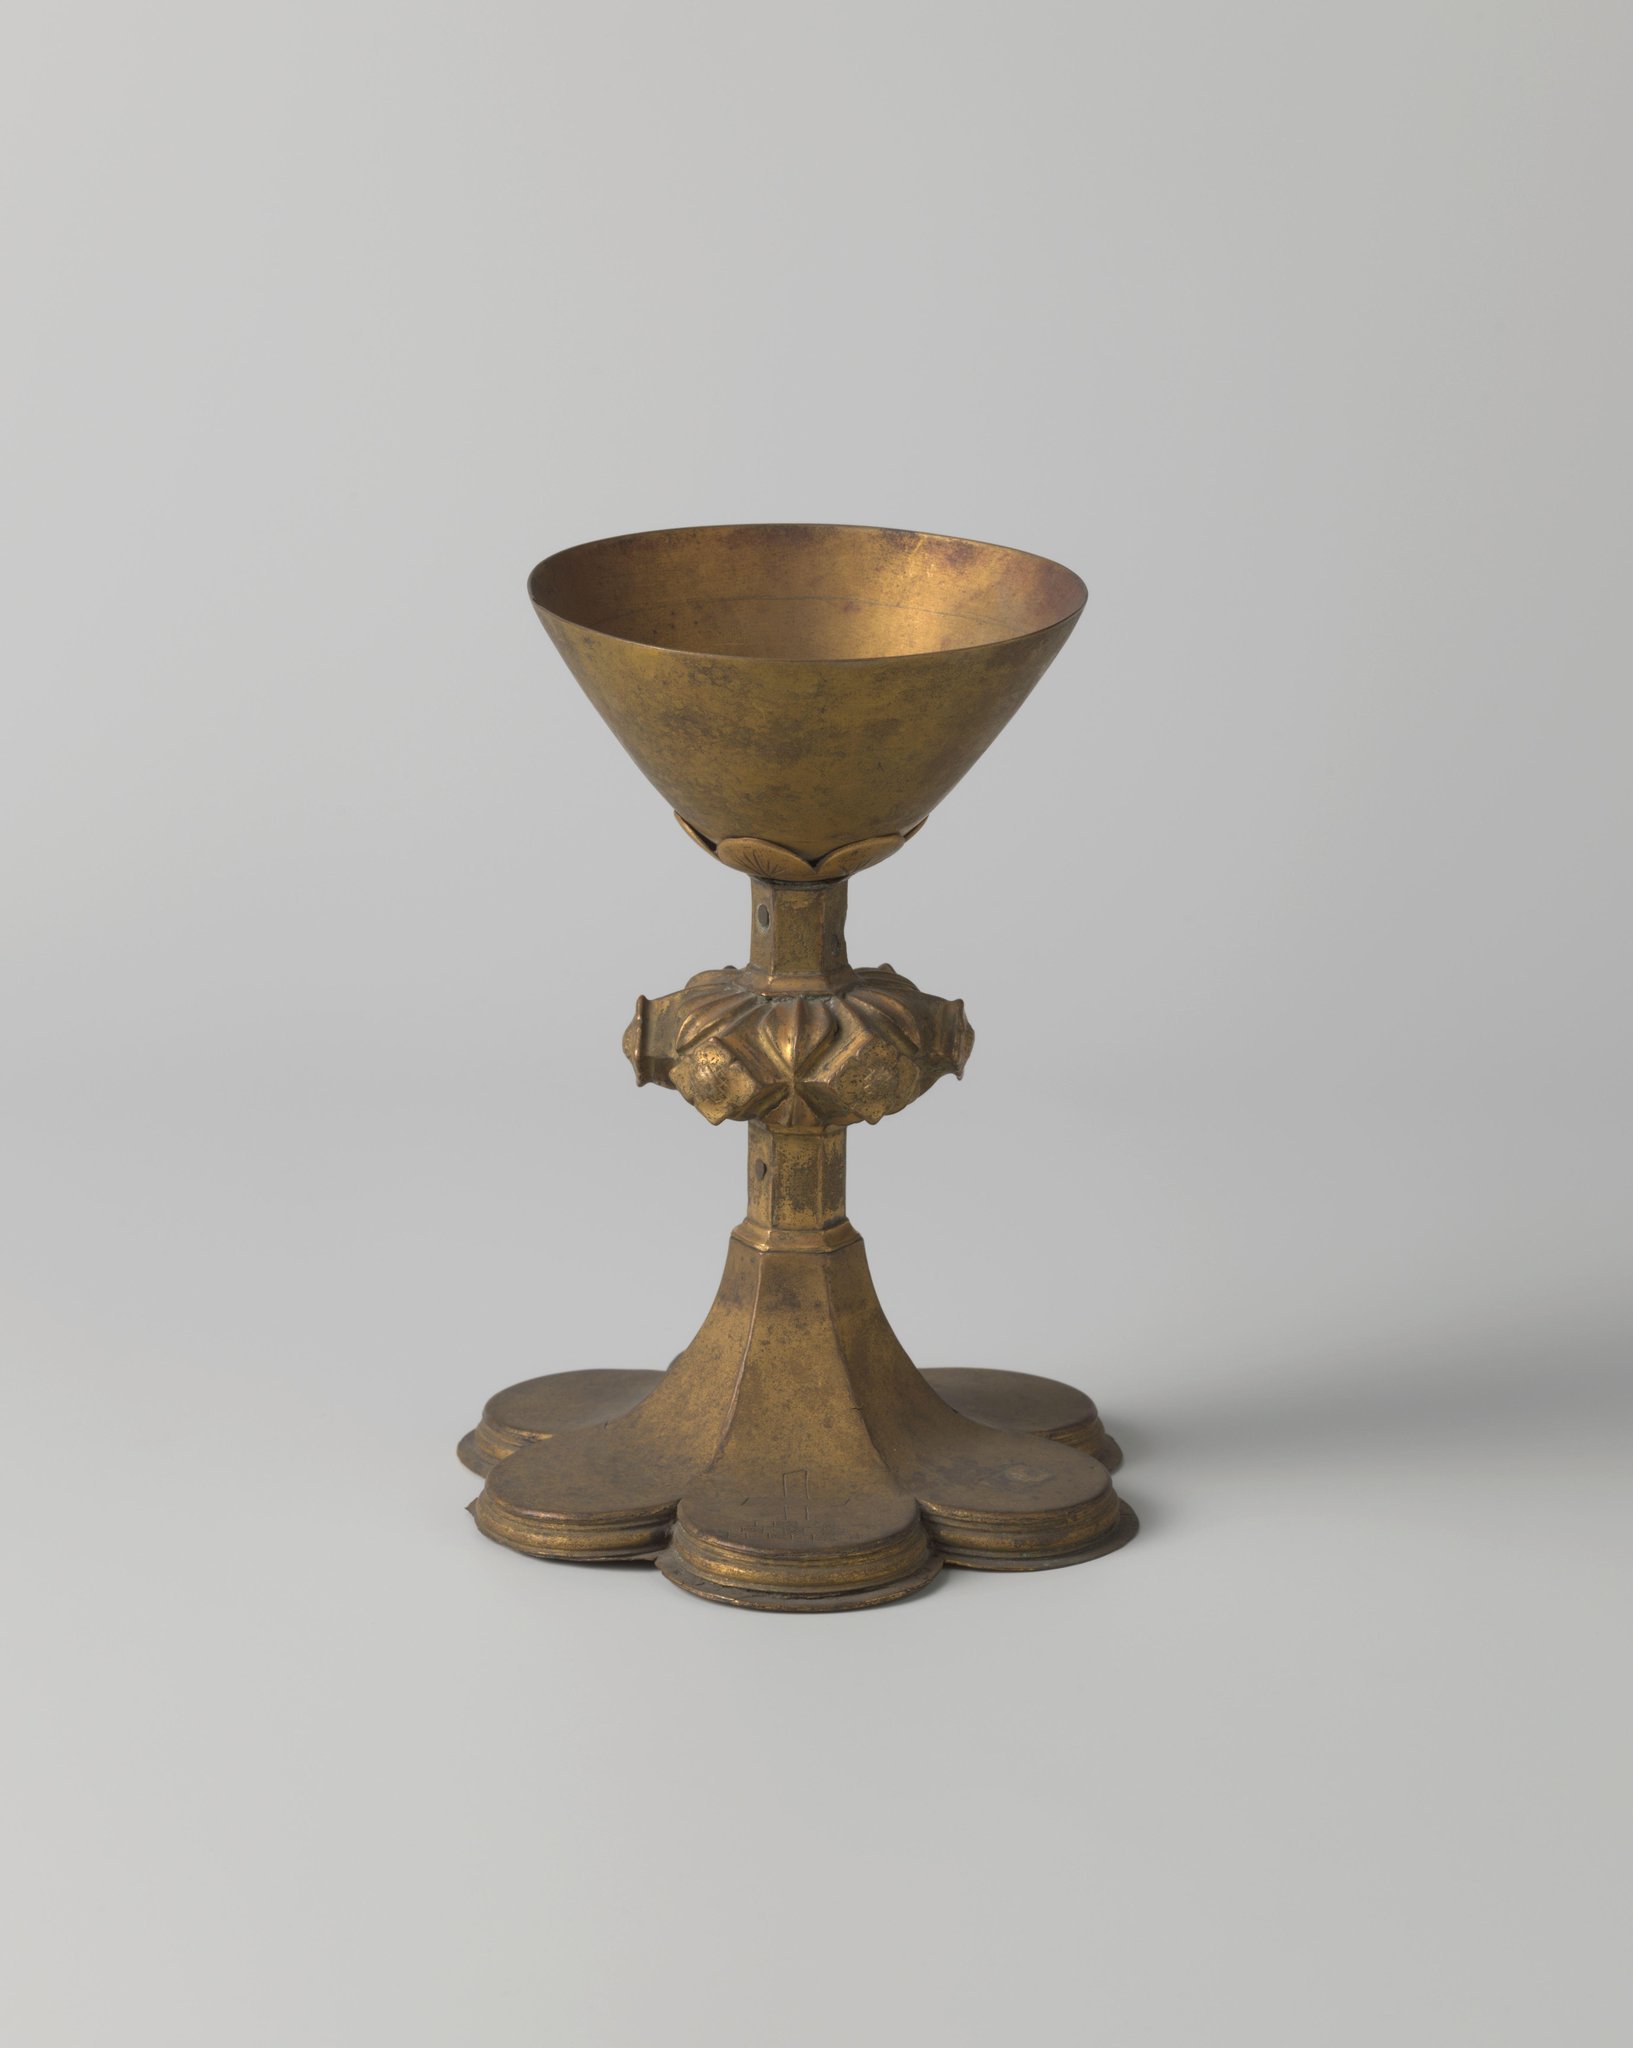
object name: chalice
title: Miskelk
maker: Anonymous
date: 1475-1525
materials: brass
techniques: metalworking, engraving, gilding, riveted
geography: germany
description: Het gedreven en geciseleerde voorwerp bestaat uit voet (met de rand), stam, nodus en cuppa. Om de stam zijn het onderste stamdeel, de nodus en het bovenste deel aangebracht en geklonken. De cuppa is op de rozet bevestigd. De voet heeft zes lobben met een geprofileerde uitlopende rand, die in zes delen tegen de voet is aangebracht. Op één van hen is een kruis met schuine einden op een geblokt veld gegraveerd. De nodus heeft zes facetten, waarop vierbladige gestileerde rozetten, alsmede aan boven- en onderkant zes bladachtige motieven zijn aangebracht. De cuppa is aan de onderzijde gevat in een zesbladige kelk met gegraveerd ornament. De voet heeft aan de onderkant twee trembleersteken, die doen vermoeden, dat hij gekeurd is.